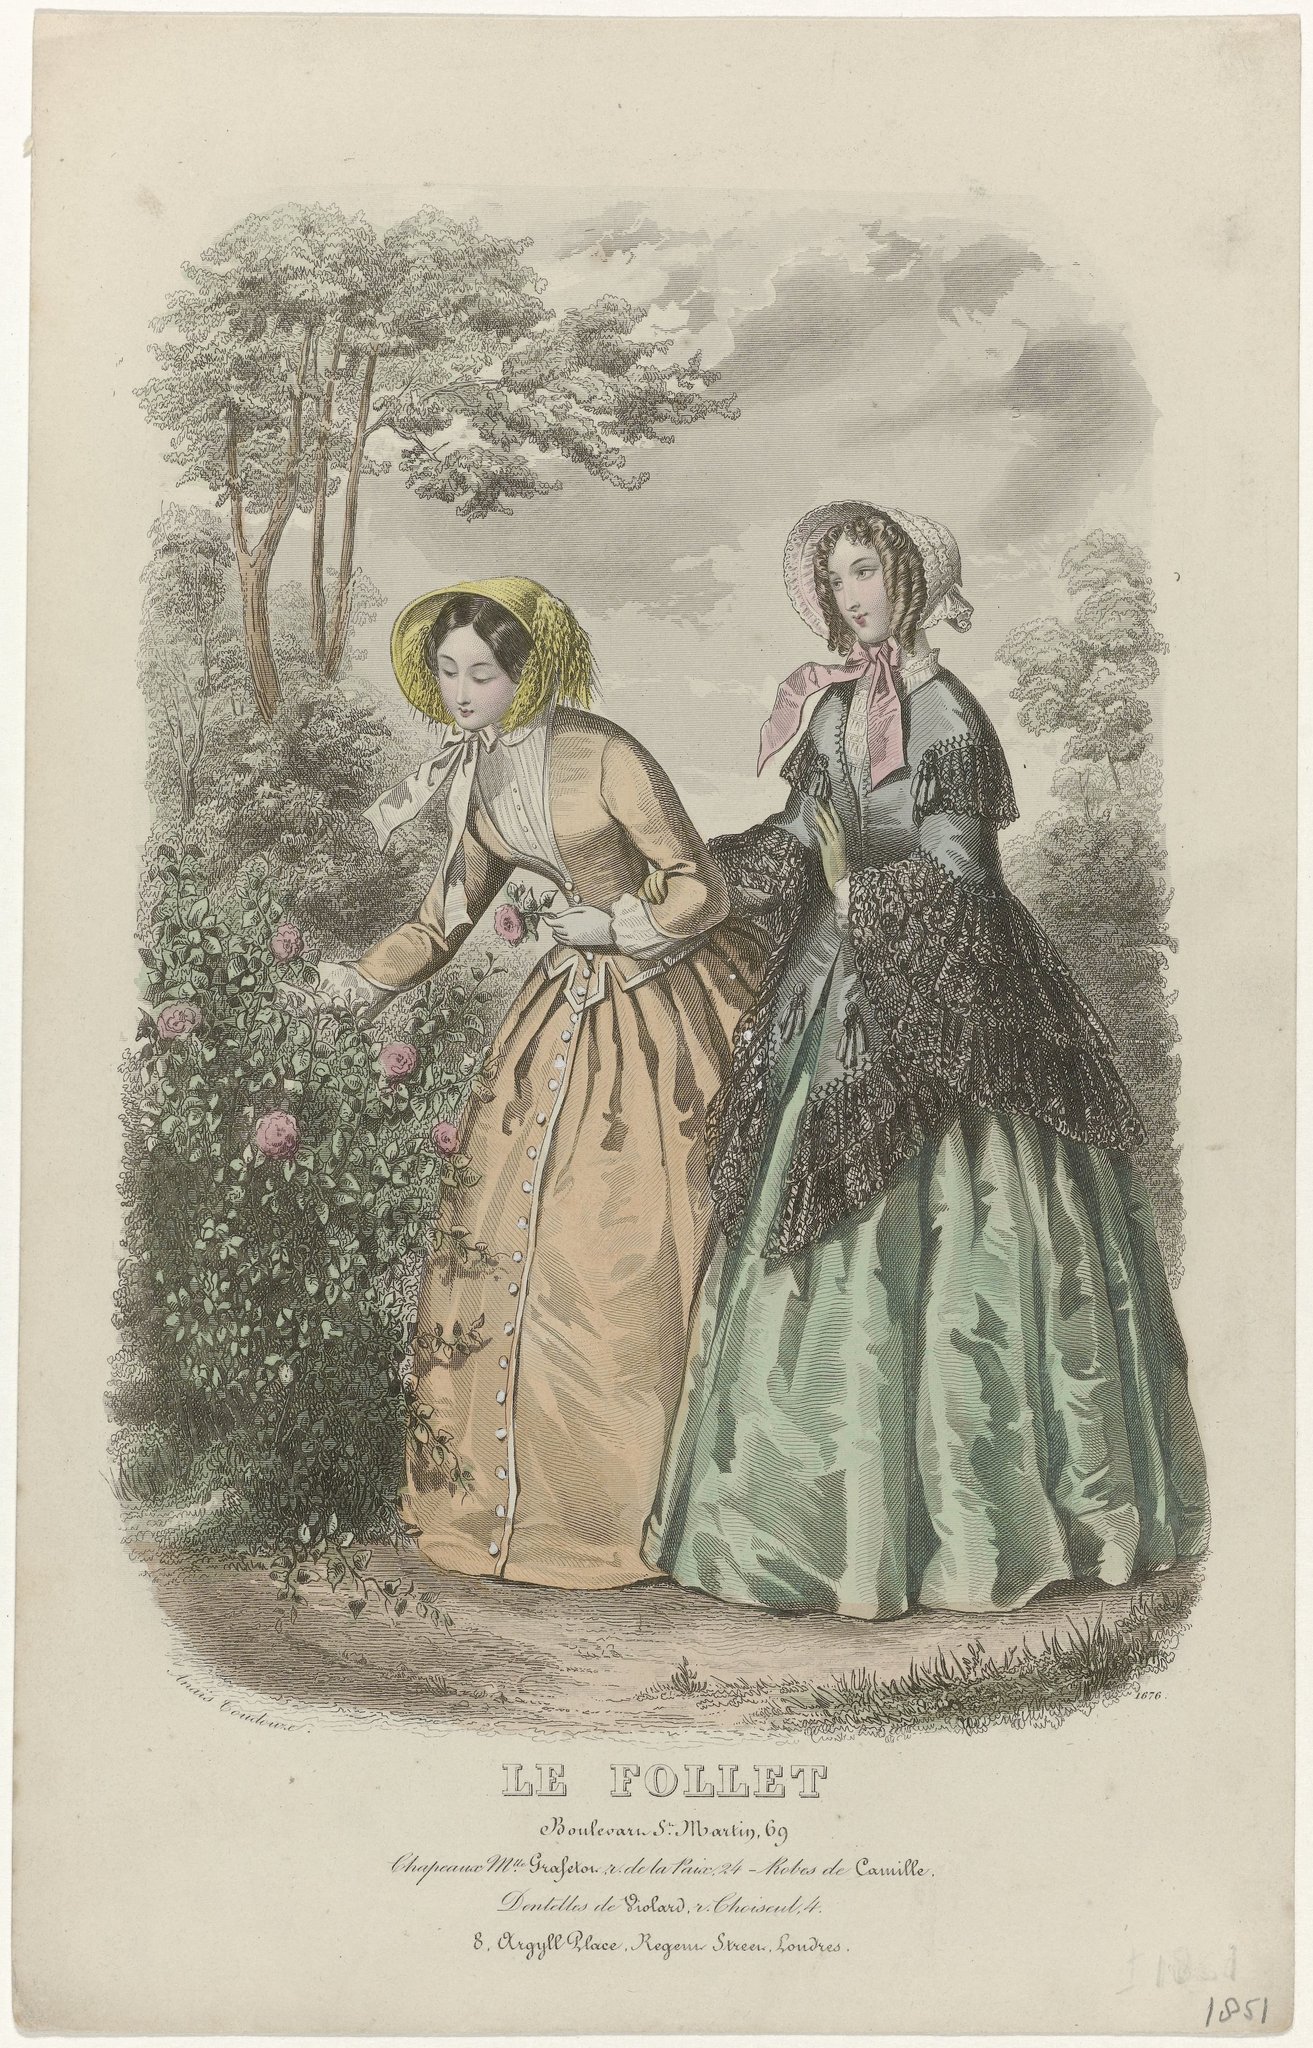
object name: fashion print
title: Le Follet, 1851, No. 1676 : Chapeaux M.lle Grafetor (...)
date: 1851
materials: paper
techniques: hand coloring, engraving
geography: paris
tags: picking flowers, flowers, lace (+ women's clothes), coat (+ women's clothes), fashion plates, head-gear: hat (+ women's clothes), gloves, mittens, etc. (+ women's clothes), neck-gear ~ clothing (+ women's clothes)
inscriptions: caption: ‘Chapeaux M.lle Grafetor, r. de la Paix, 24 - Robes de Camille. Dentelles de Violard, r. Choiseul, 4.’, address: ‘Boulevart S.t Martin, 69 / 8 Argyll Place, Regent Street, Londres.’, title: ‘Le Follet’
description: Twee vrouwen, van wie één bloemen aan het plukken is, staan gearmd in een tuin. Volgens het onderschrift: hoeden van Grafetor. Japonnen van Camille. Kant van Violard. Prent uit het modetijdschrift Le Follet Courrier des Salons (novembre 1829-octobre 1882).